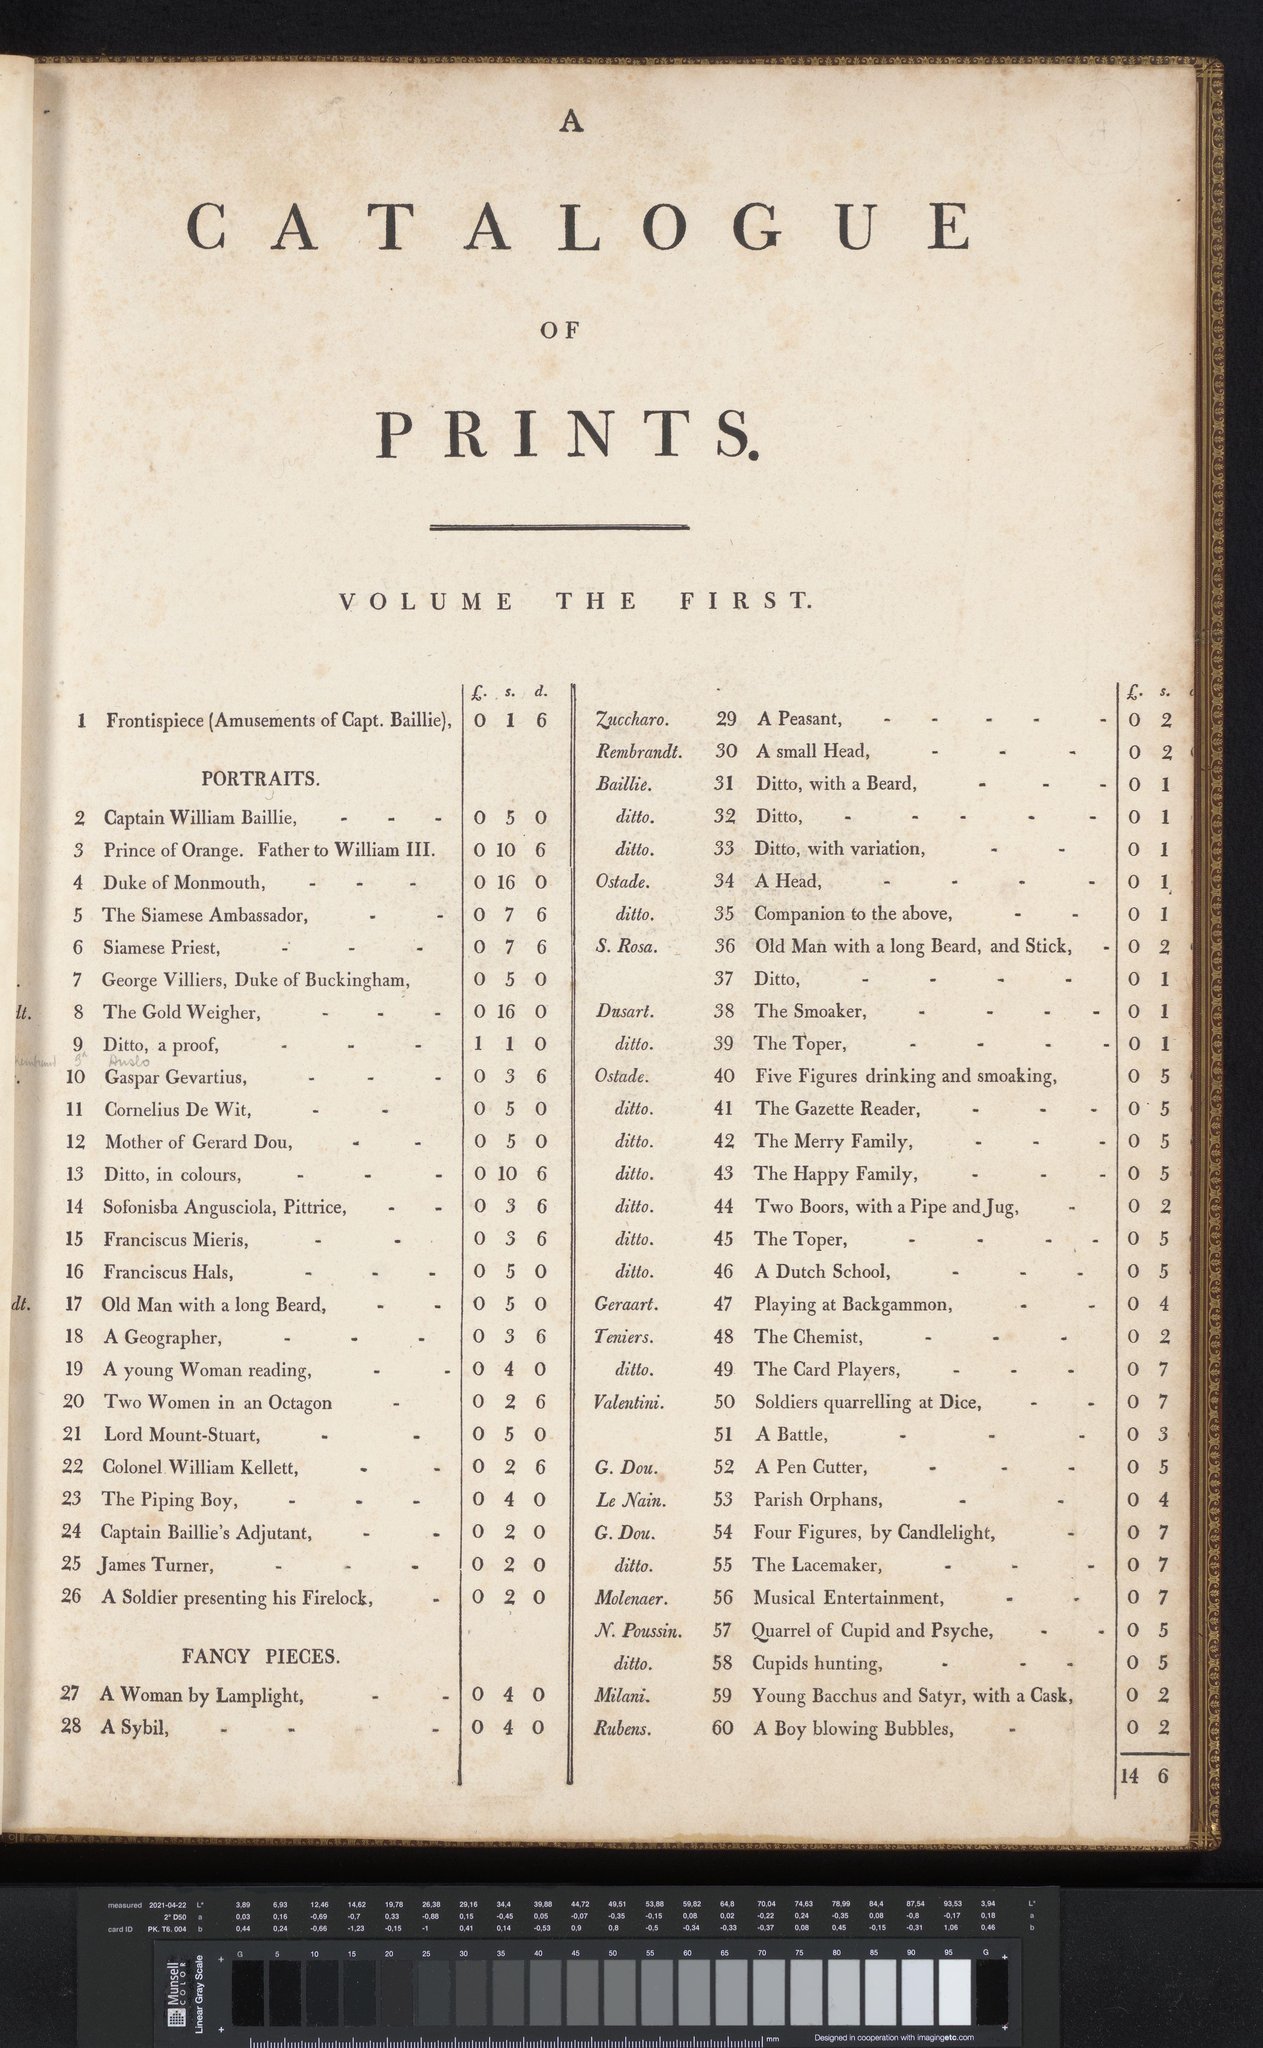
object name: text sheet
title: A Catalogue of Prints. Volume the First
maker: Anonymous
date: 1770-1830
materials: paper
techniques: letterpress printing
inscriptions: collector's mark: Lugt 2166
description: Het tekstblad maakt deel uit van een album.